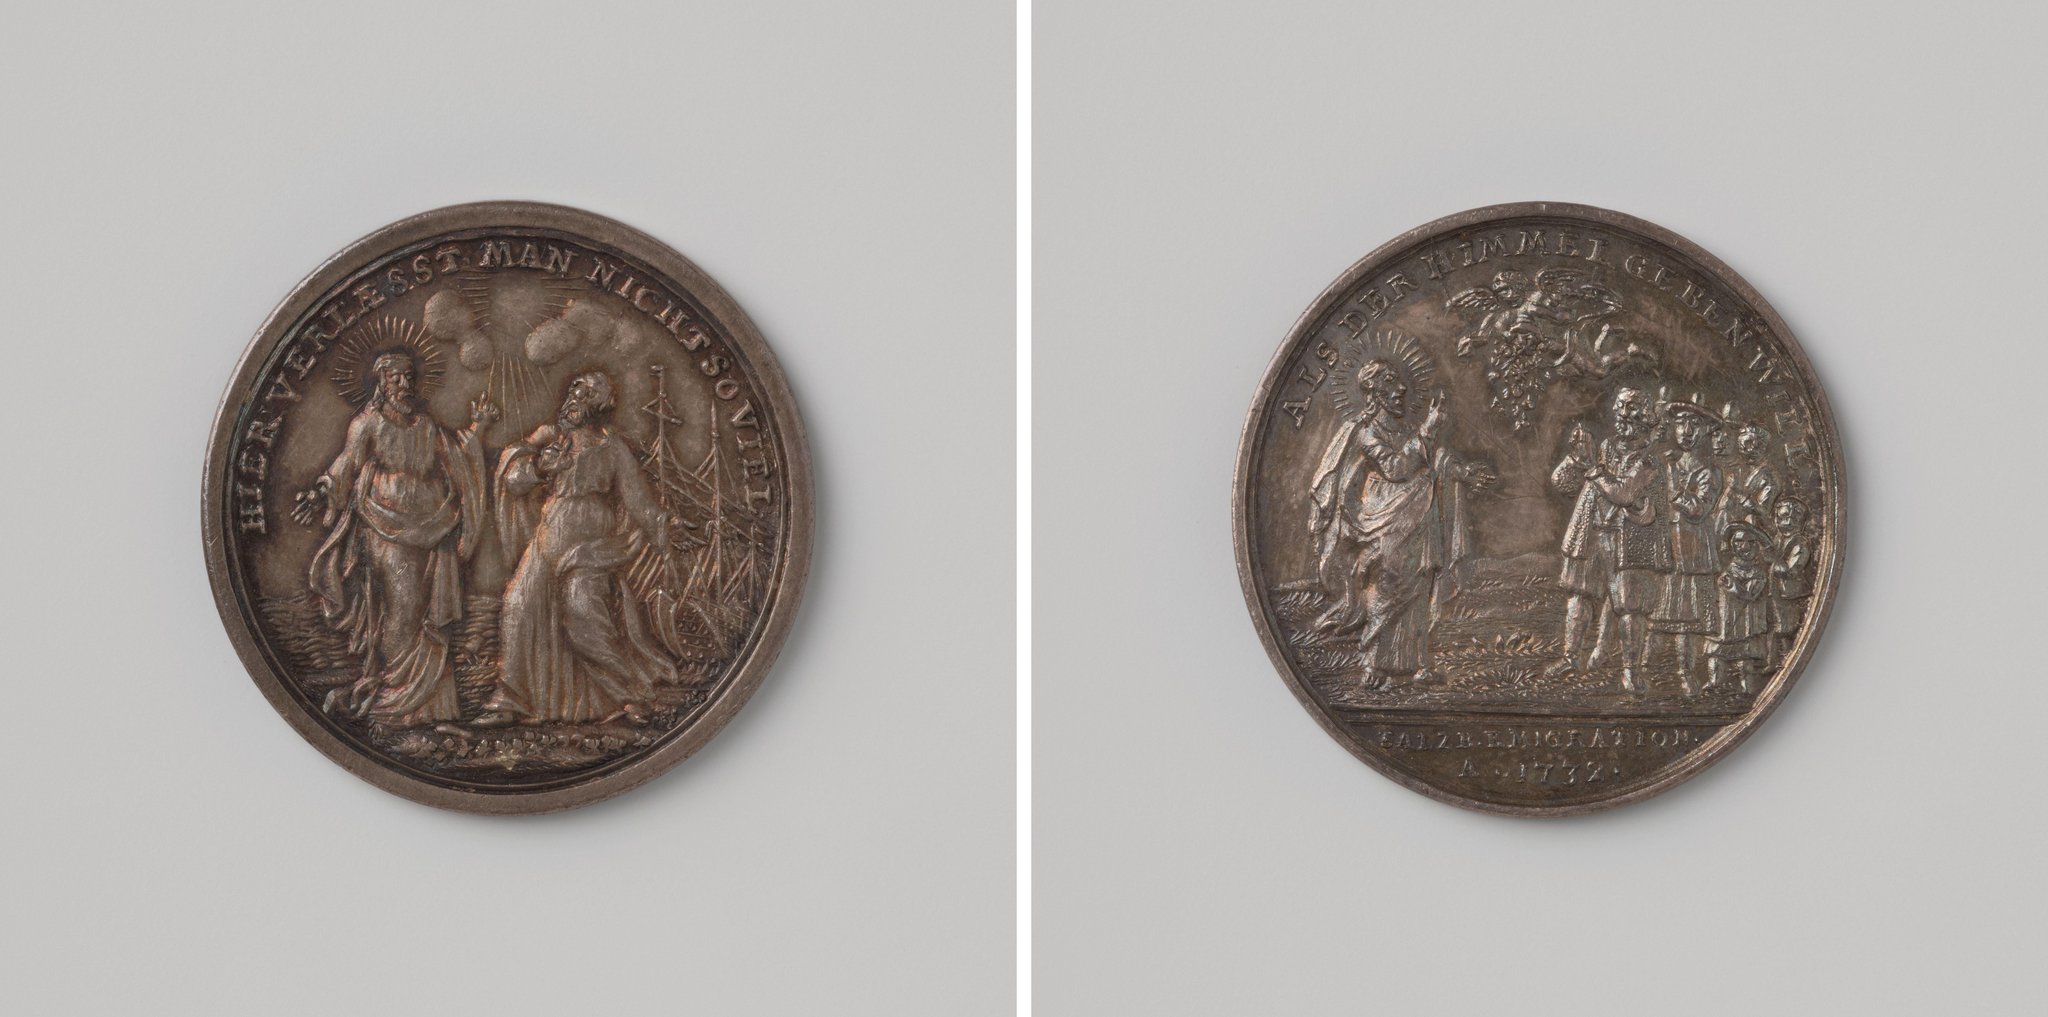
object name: history medal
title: Uittocht der Salzburger emigranten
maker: Anonymous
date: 1732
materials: silver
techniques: striking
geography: germany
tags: drievuldigheidskerk, uittocht van salzburger emigranten (1732)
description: Zilveren penning. Voorzijde: Christus en Petrus (?) aan water, op achtergrond schip binnen omschrift. Keerzijde: Christus spreekt groep mensen toe, terwijl engel hoorn van overvloed boven hen leeg stort binnen omschrift; afsnede: opschrift